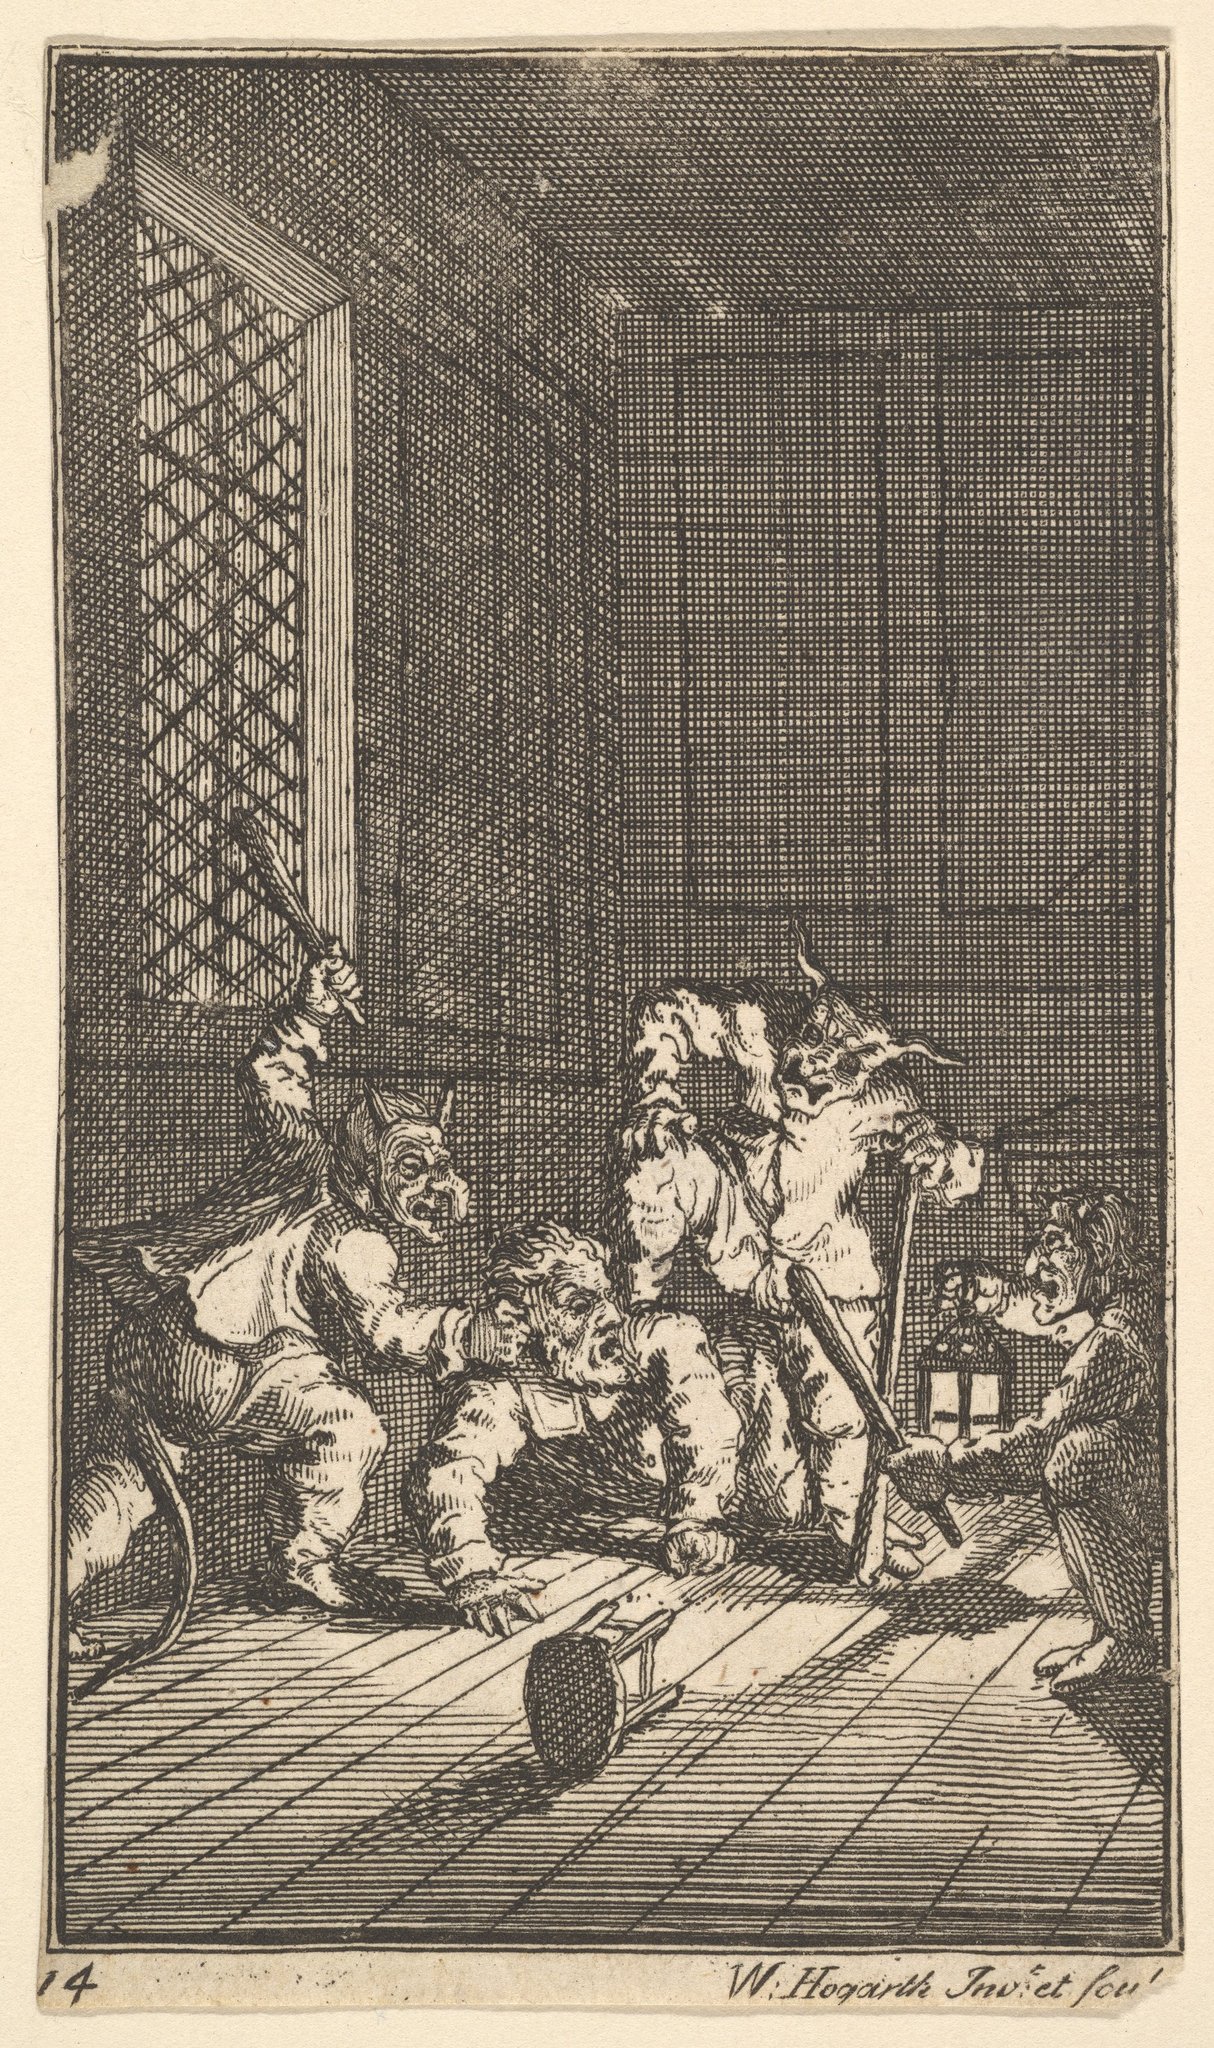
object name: print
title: Hudibras Catechized (Seventeen Small Illustrations for Samuel Butler's Hudibras, no. 14)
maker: william hogarth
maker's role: artist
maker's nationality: british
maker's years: 1697-1764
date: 1721-1726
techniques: engraving, etching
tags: men